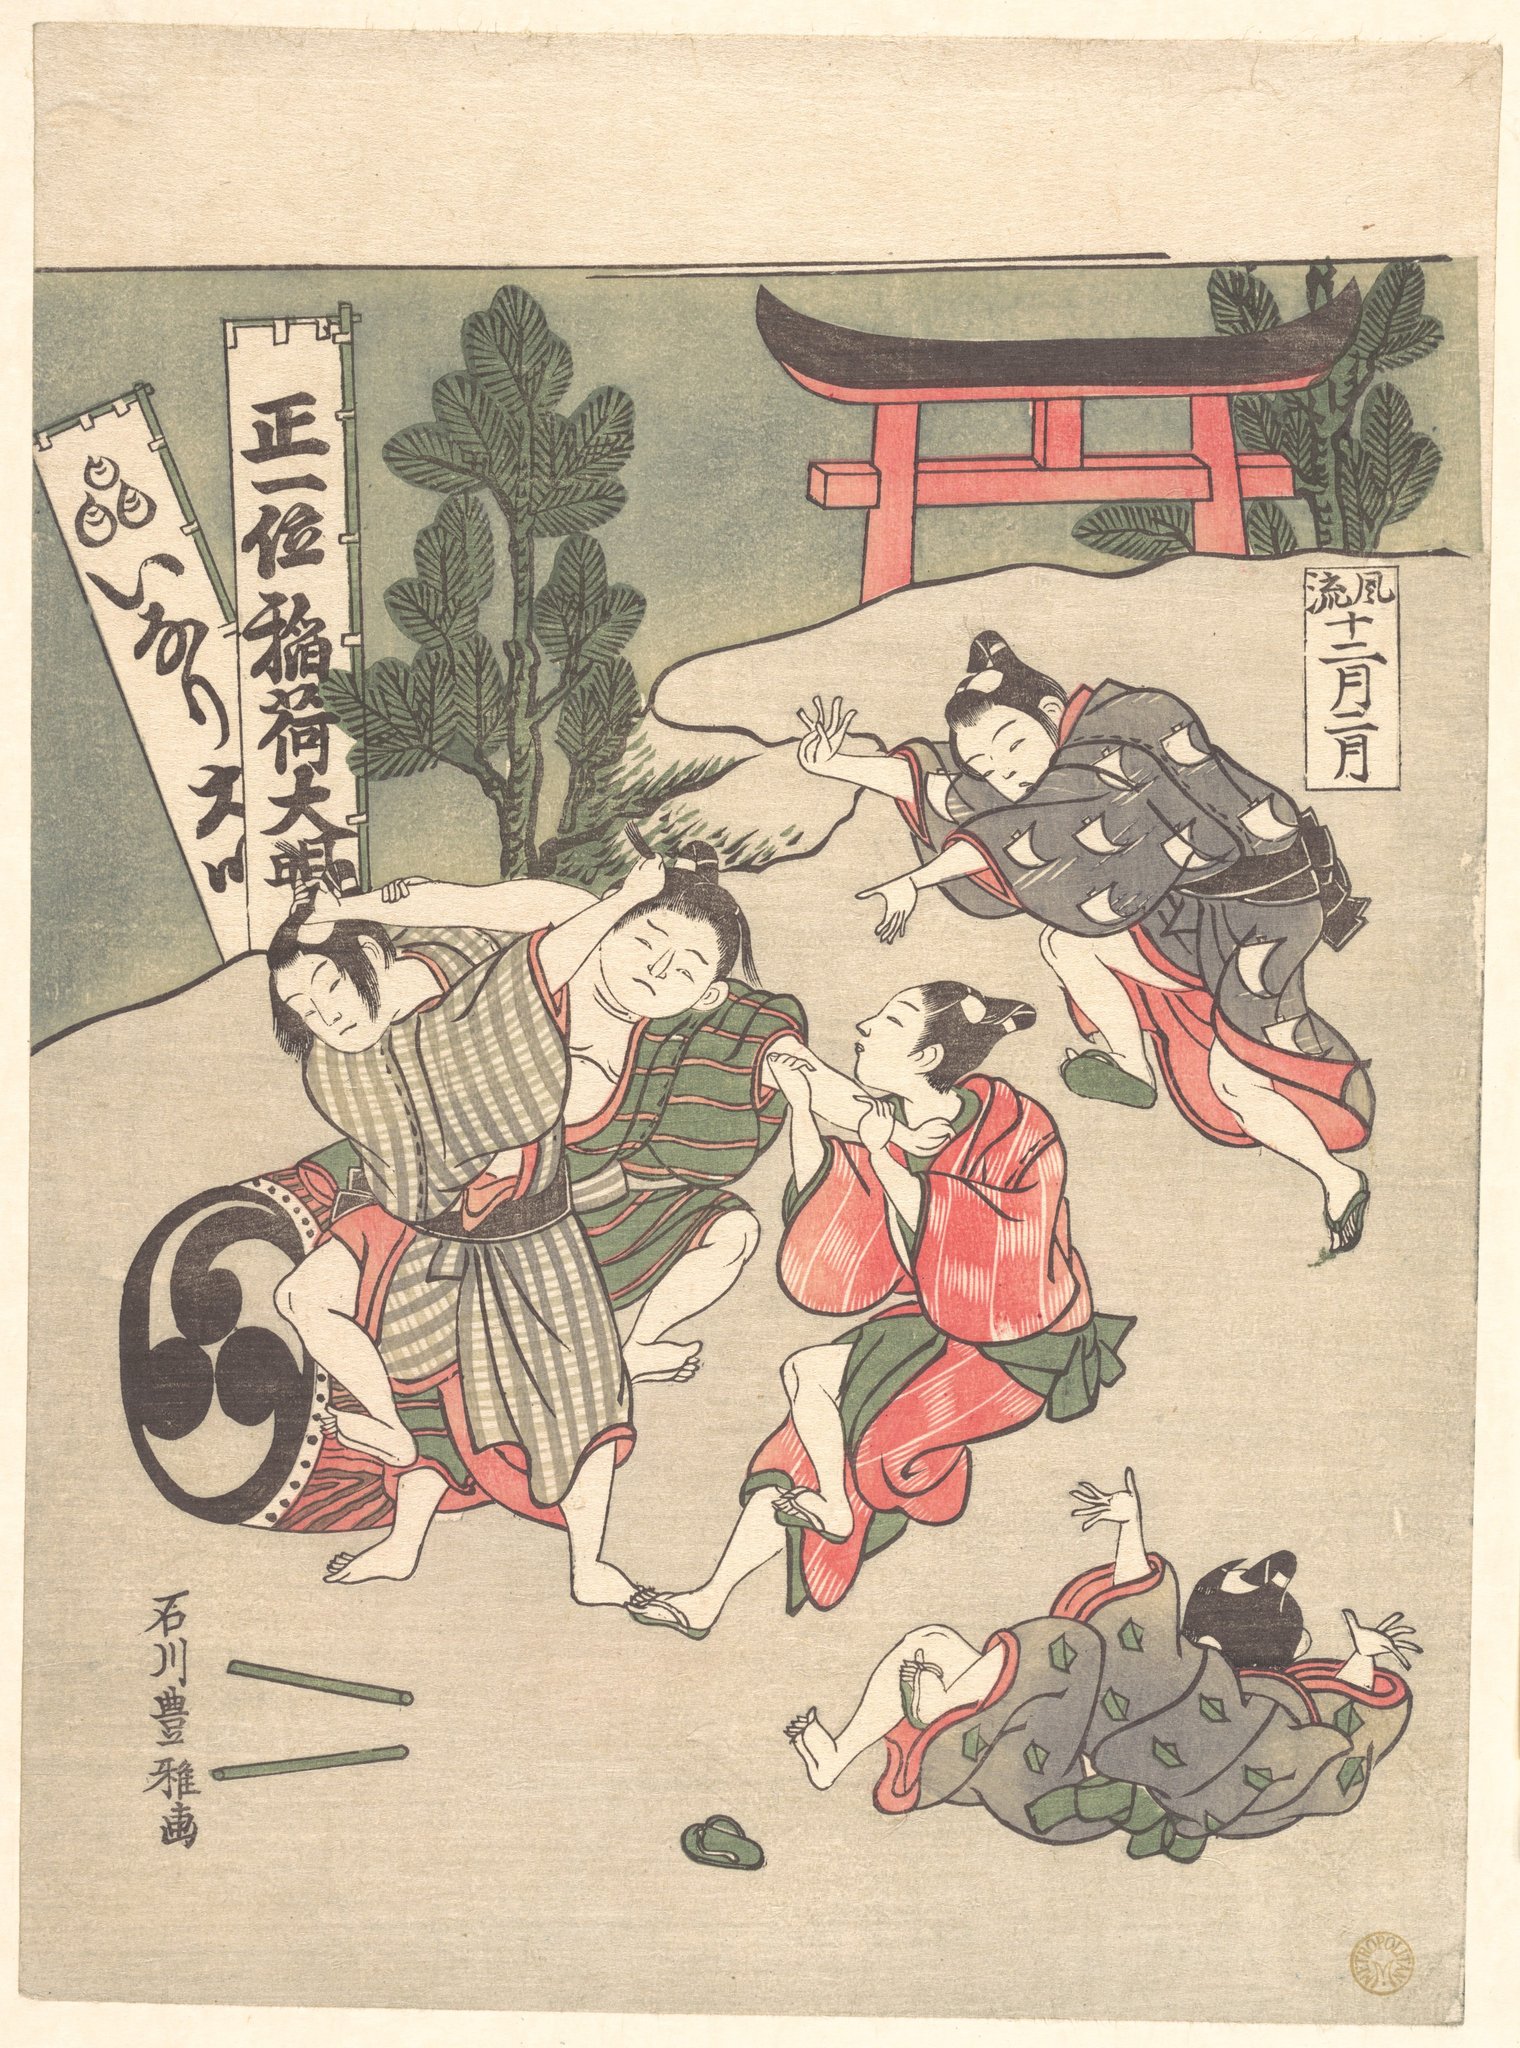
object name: print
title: The Second Month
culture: japanese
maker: ishikawa toyomasa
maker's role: artist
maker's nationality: japanese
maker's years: 1770-1790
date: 1767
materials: ink, paper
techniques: woodblock print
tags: boys,drums